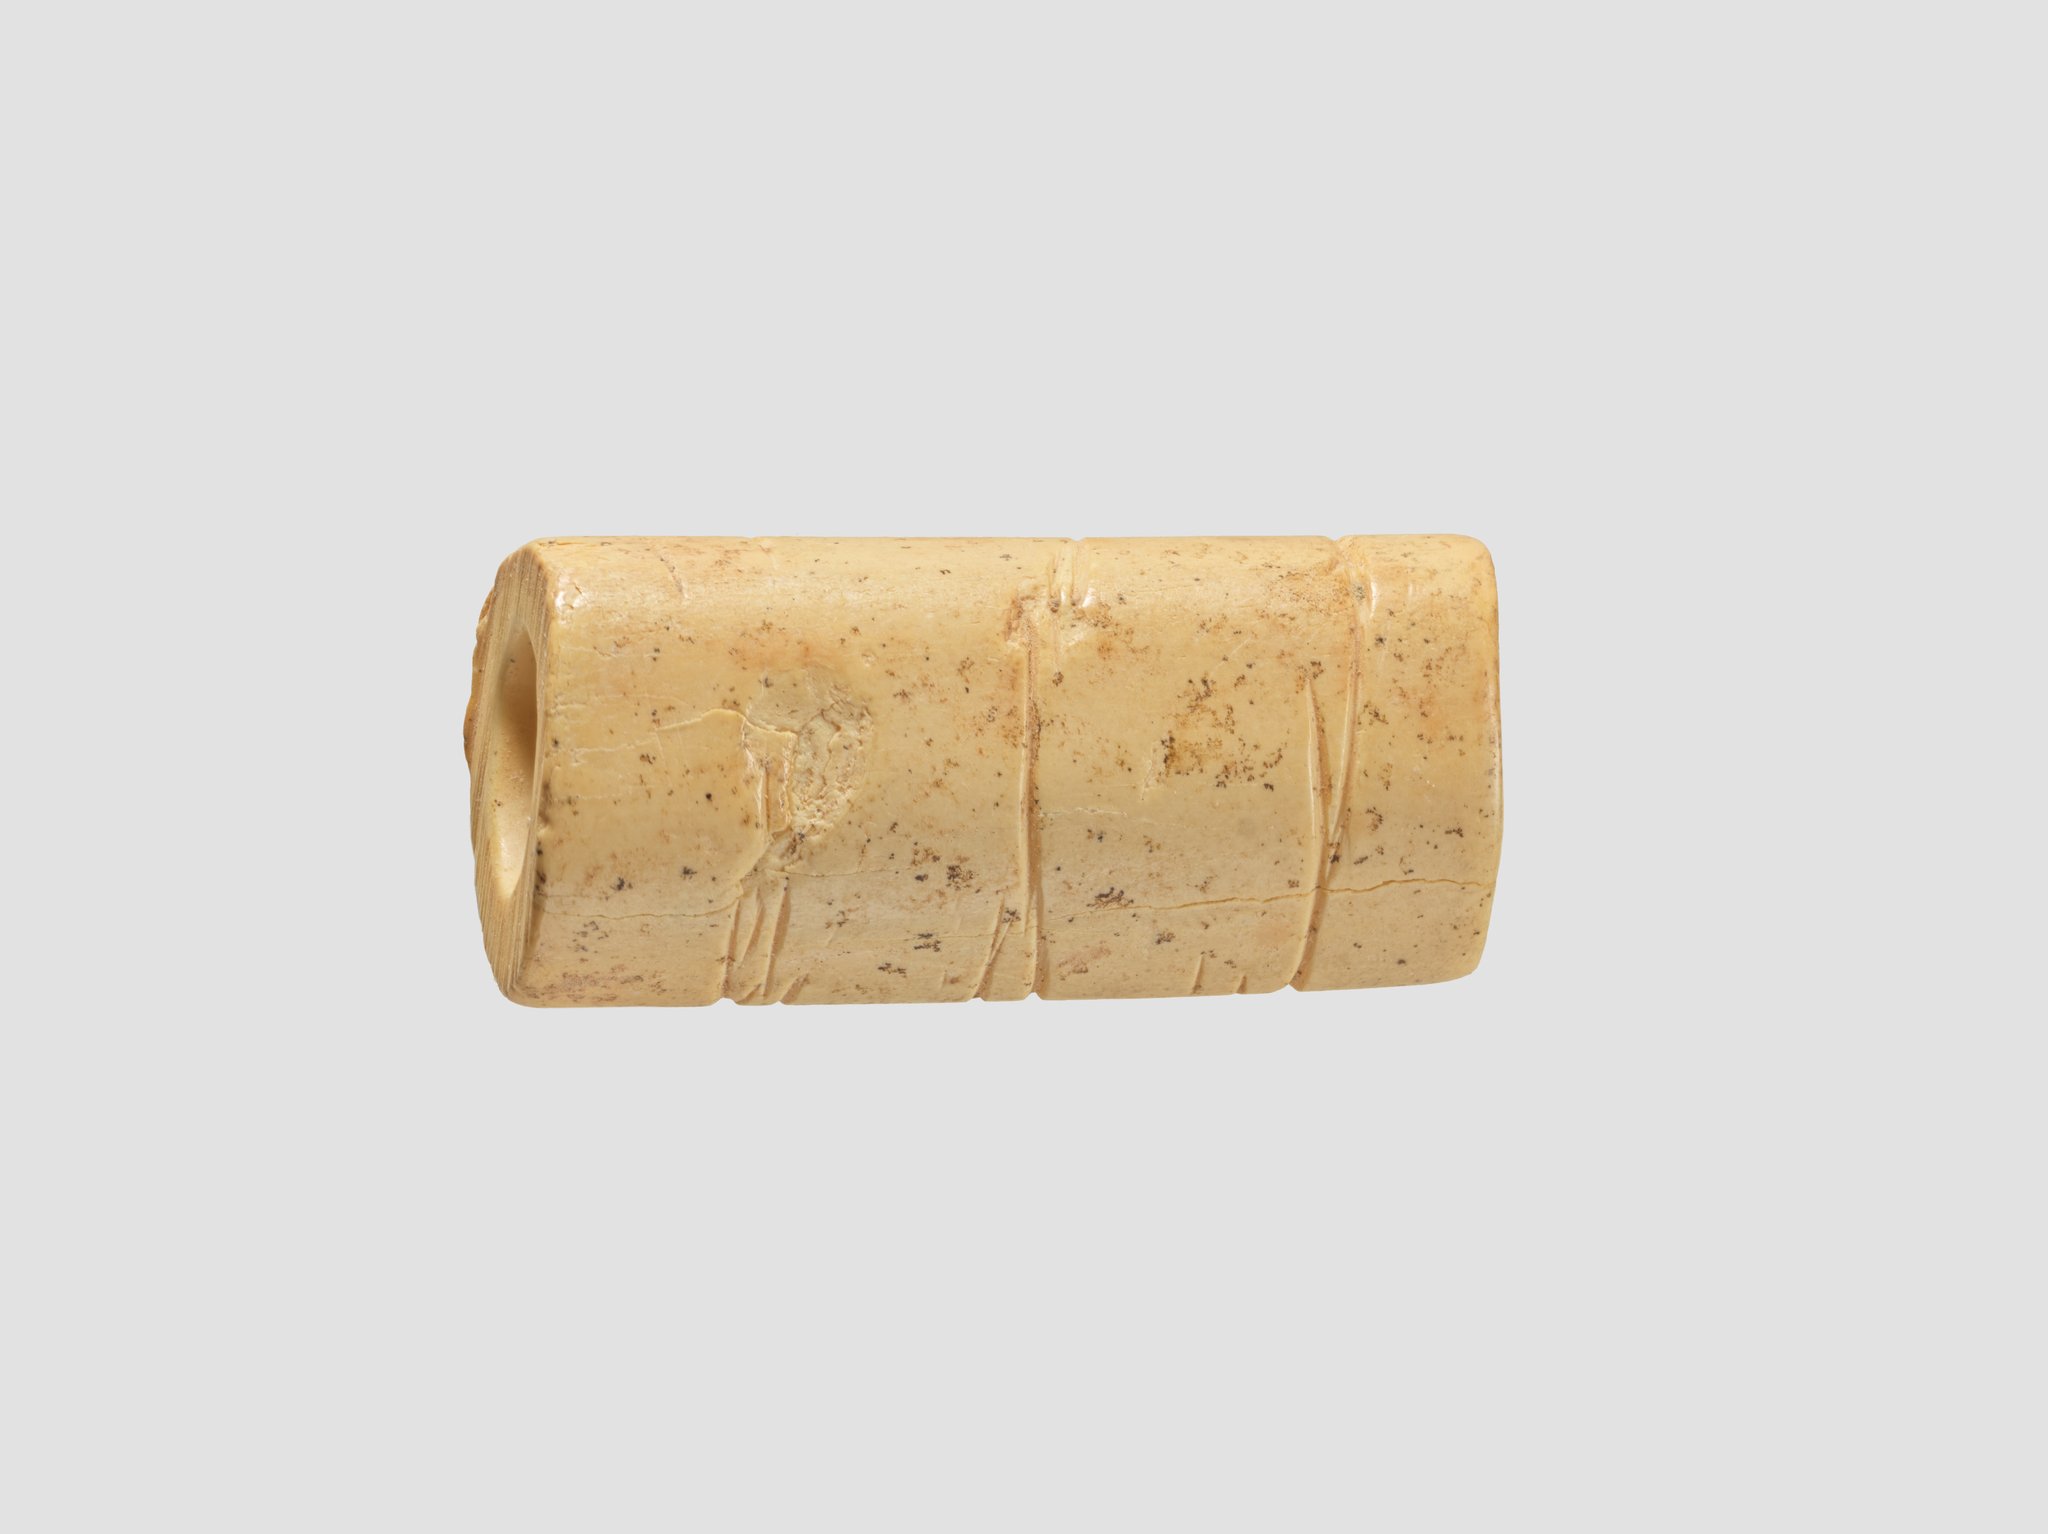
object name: bead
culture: parthian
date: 1-100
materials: bone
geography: iran